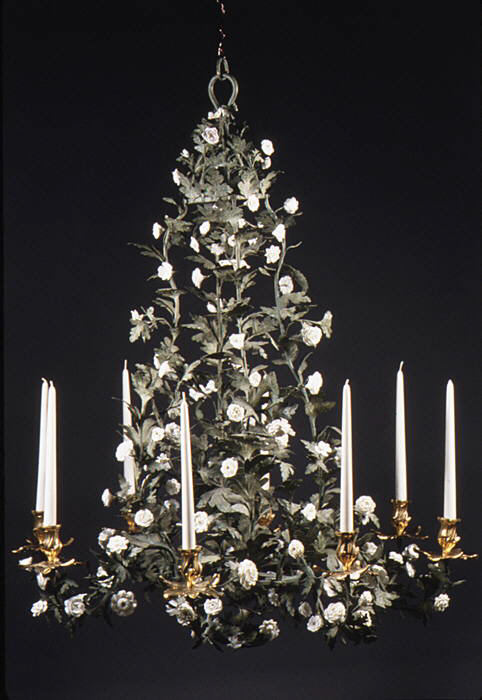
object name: chandelier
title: Eight-light chandelier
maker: vincennes manufactory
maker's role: maker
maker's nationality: french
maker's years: 1740-1756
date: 1765-1770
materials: gilt bronze, iron, soft paste porcelain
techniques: painting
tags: flowers